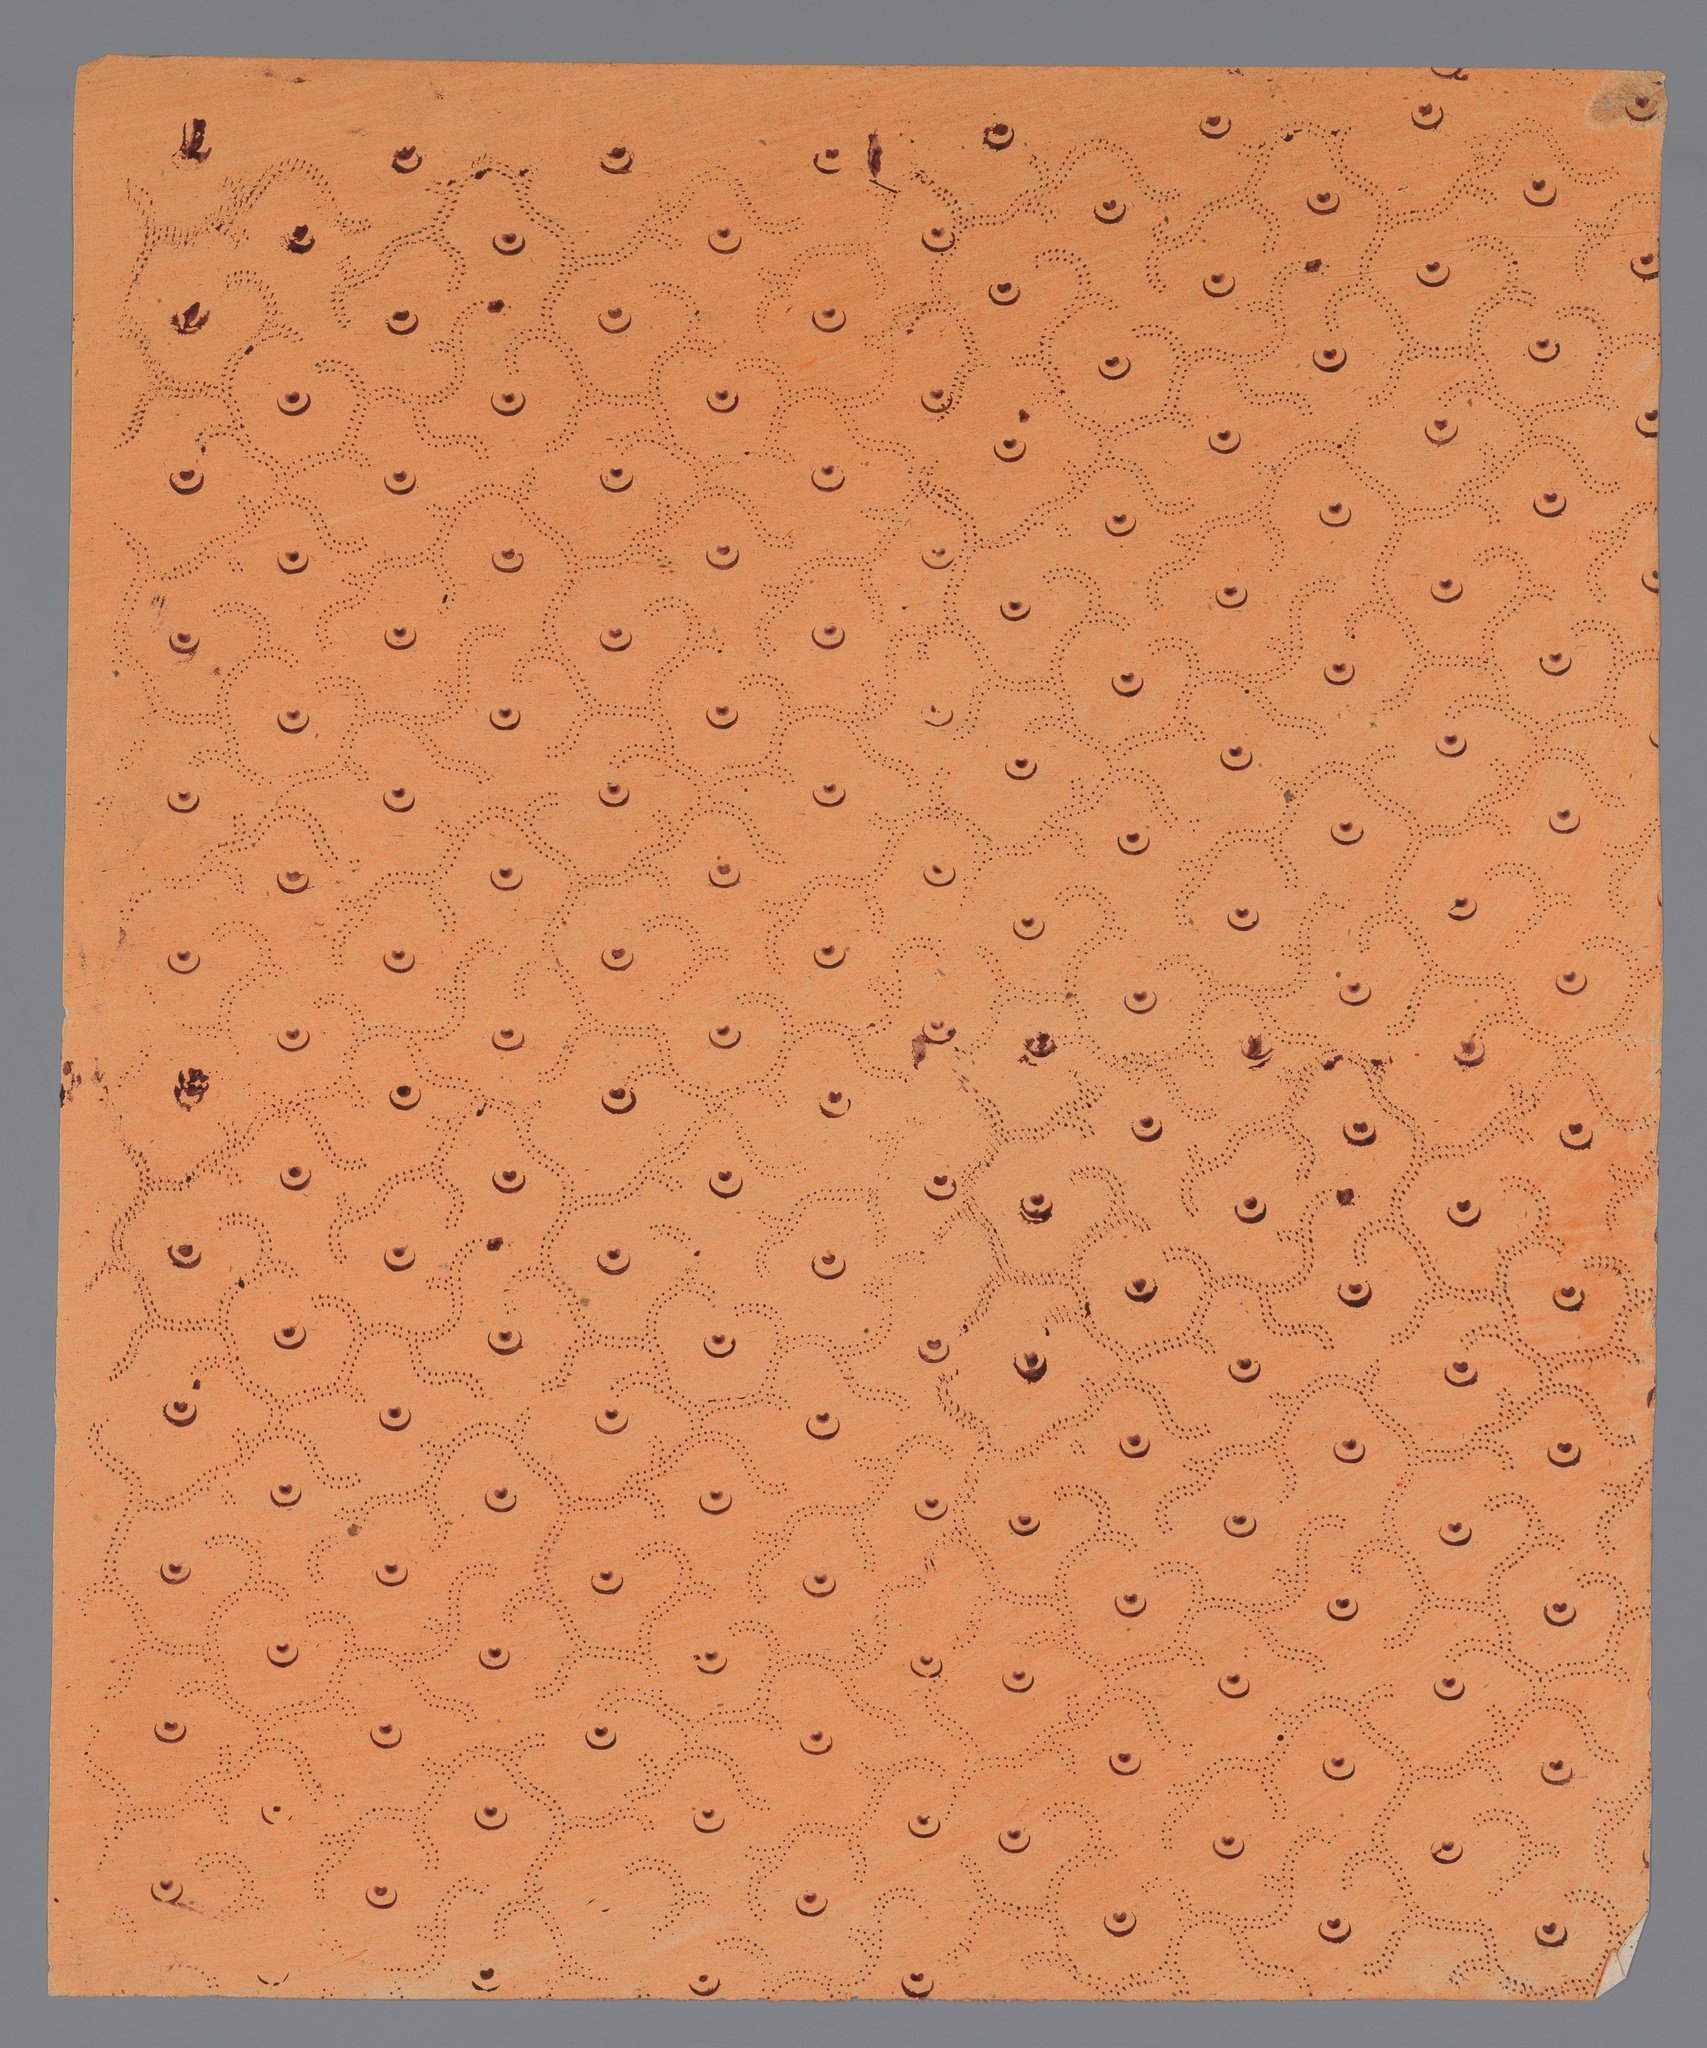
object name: printed paper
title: Blad met patroon van stippen en lijnen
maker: Anonymous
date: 1850-1950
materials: lacquer, paper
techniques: printing block, lacquer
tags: fantasy ornament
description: Blad met patroon van stippen tussen kronkelende stippellijnen.